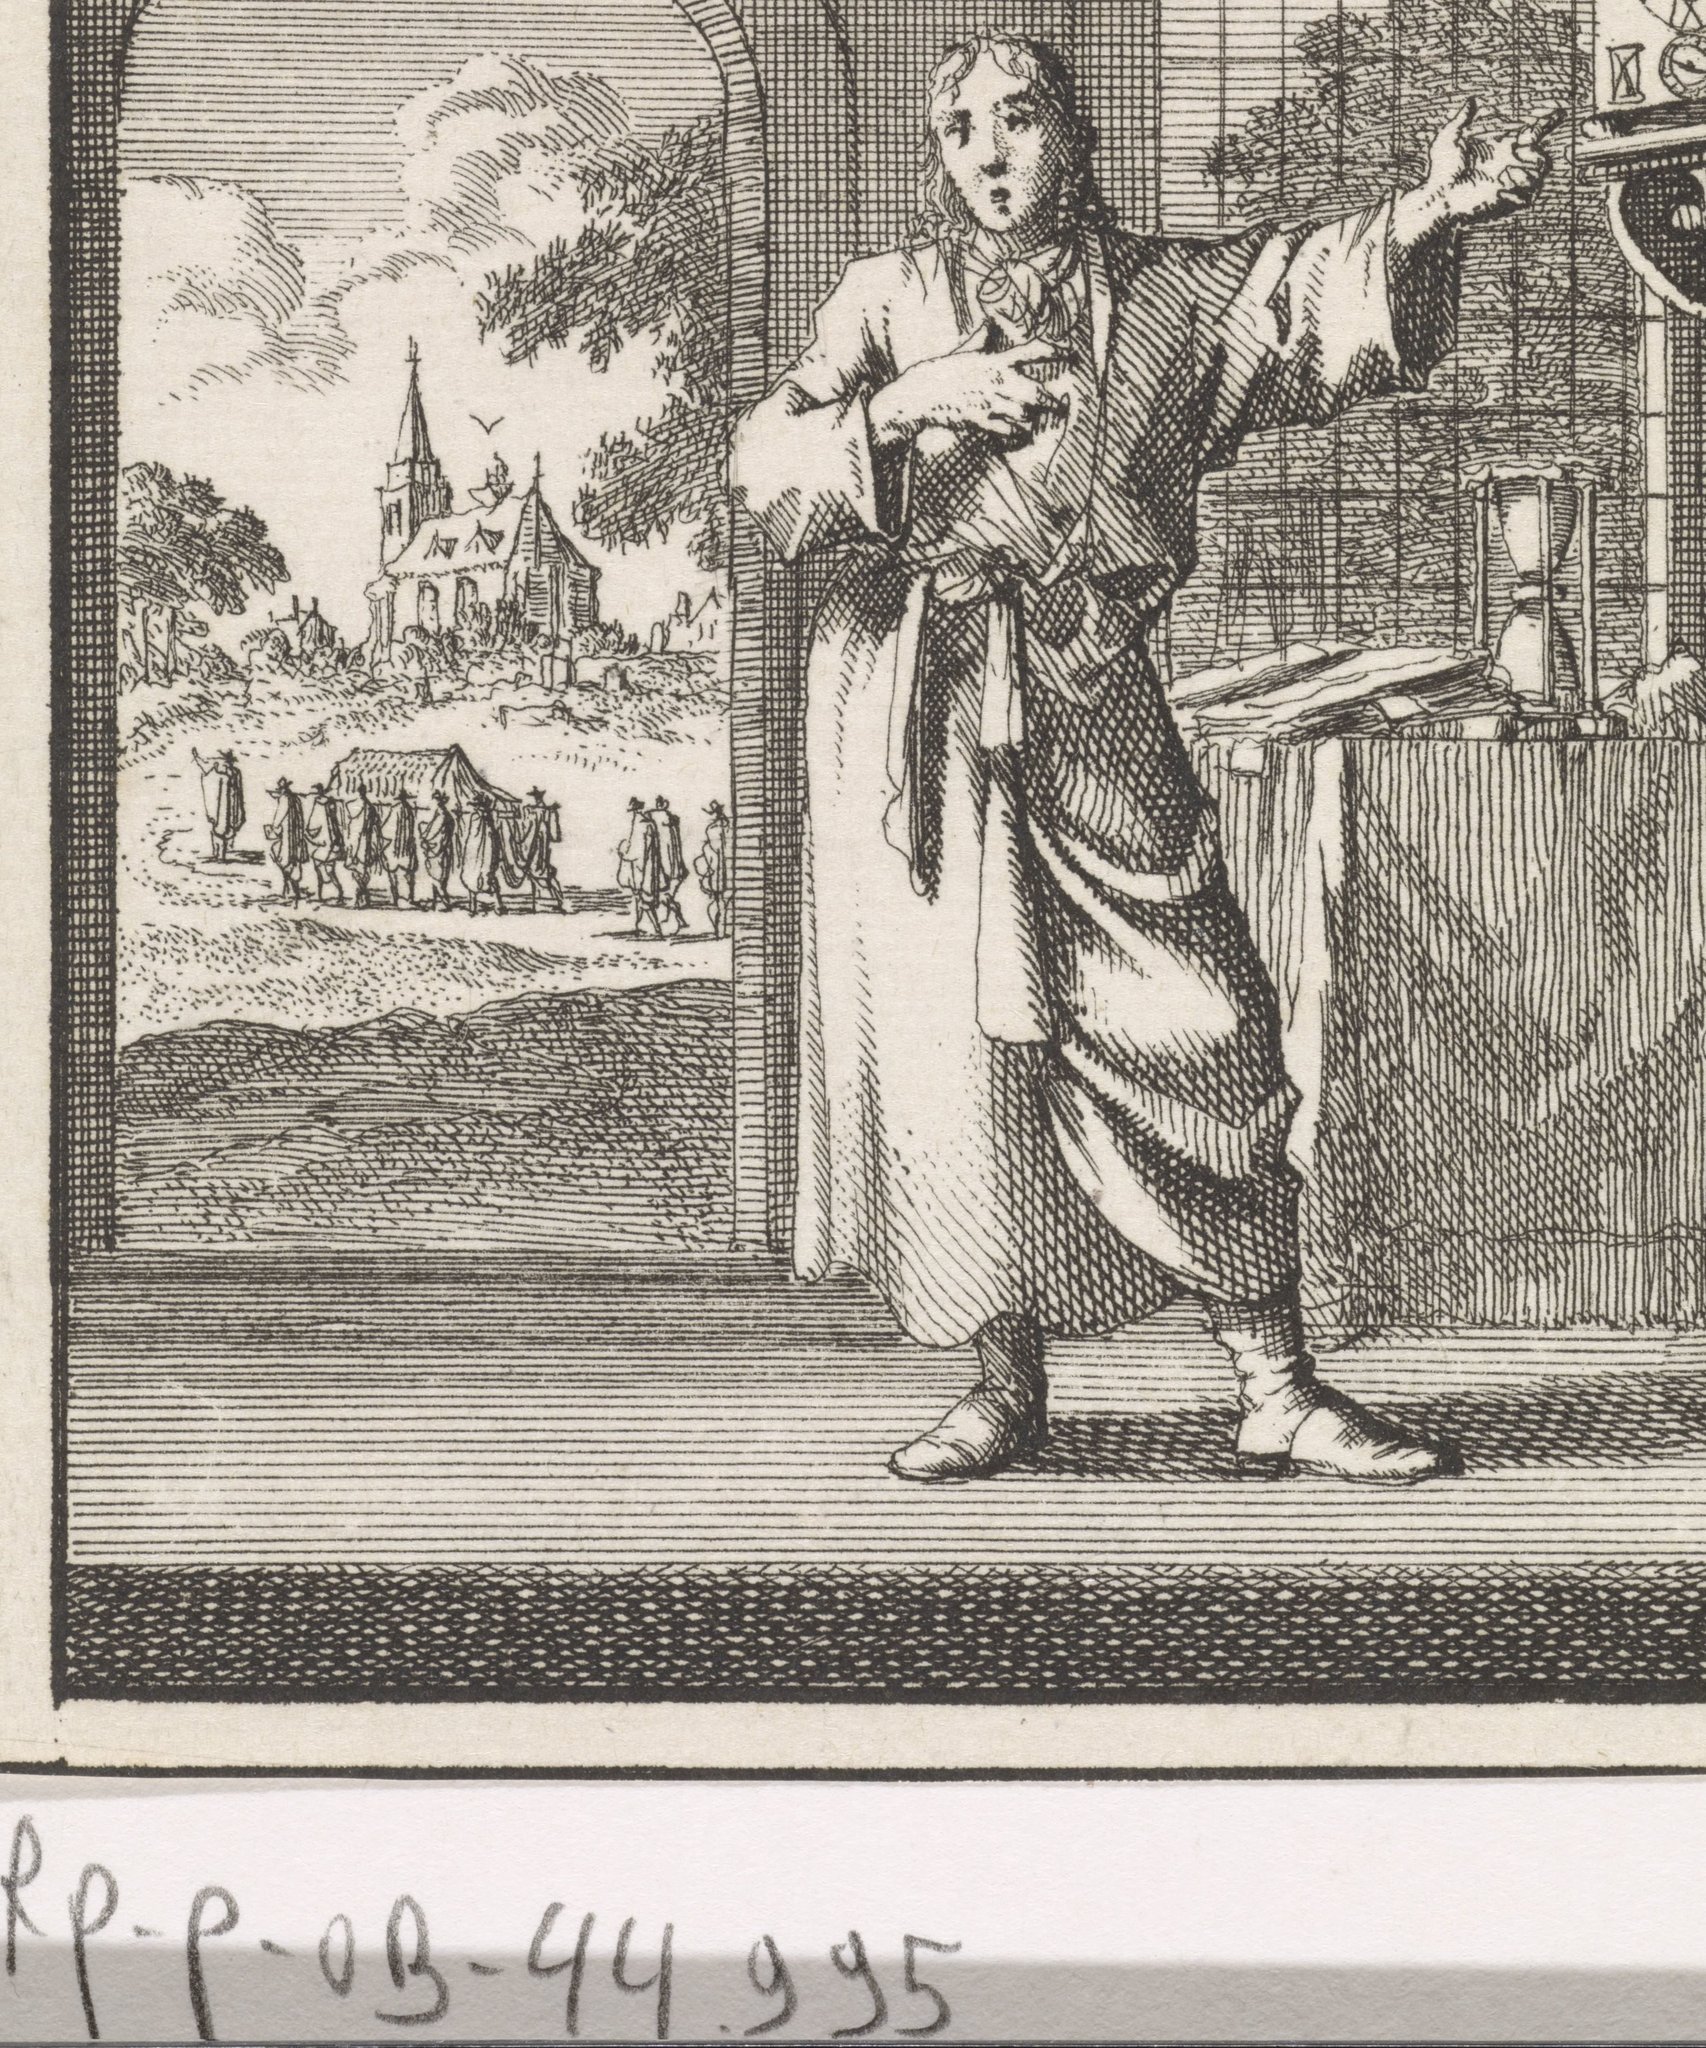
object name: print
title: Binnenshuis wijst een man naar een hangklok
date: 1700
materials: paper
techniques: etching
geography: amsterdam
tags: cortege, funeral procession, 'vanitas' symbols, clock, communal rooms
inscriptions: collector's mark: Lugt 2228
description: Boekillustratie voor Jan Huygen. Stichtelyke rymen op verscheiden stoffen. Amsterdam: Gedrukt door Jacobus van Herdenberg voor Jan Huygen, 1700, p. 202.